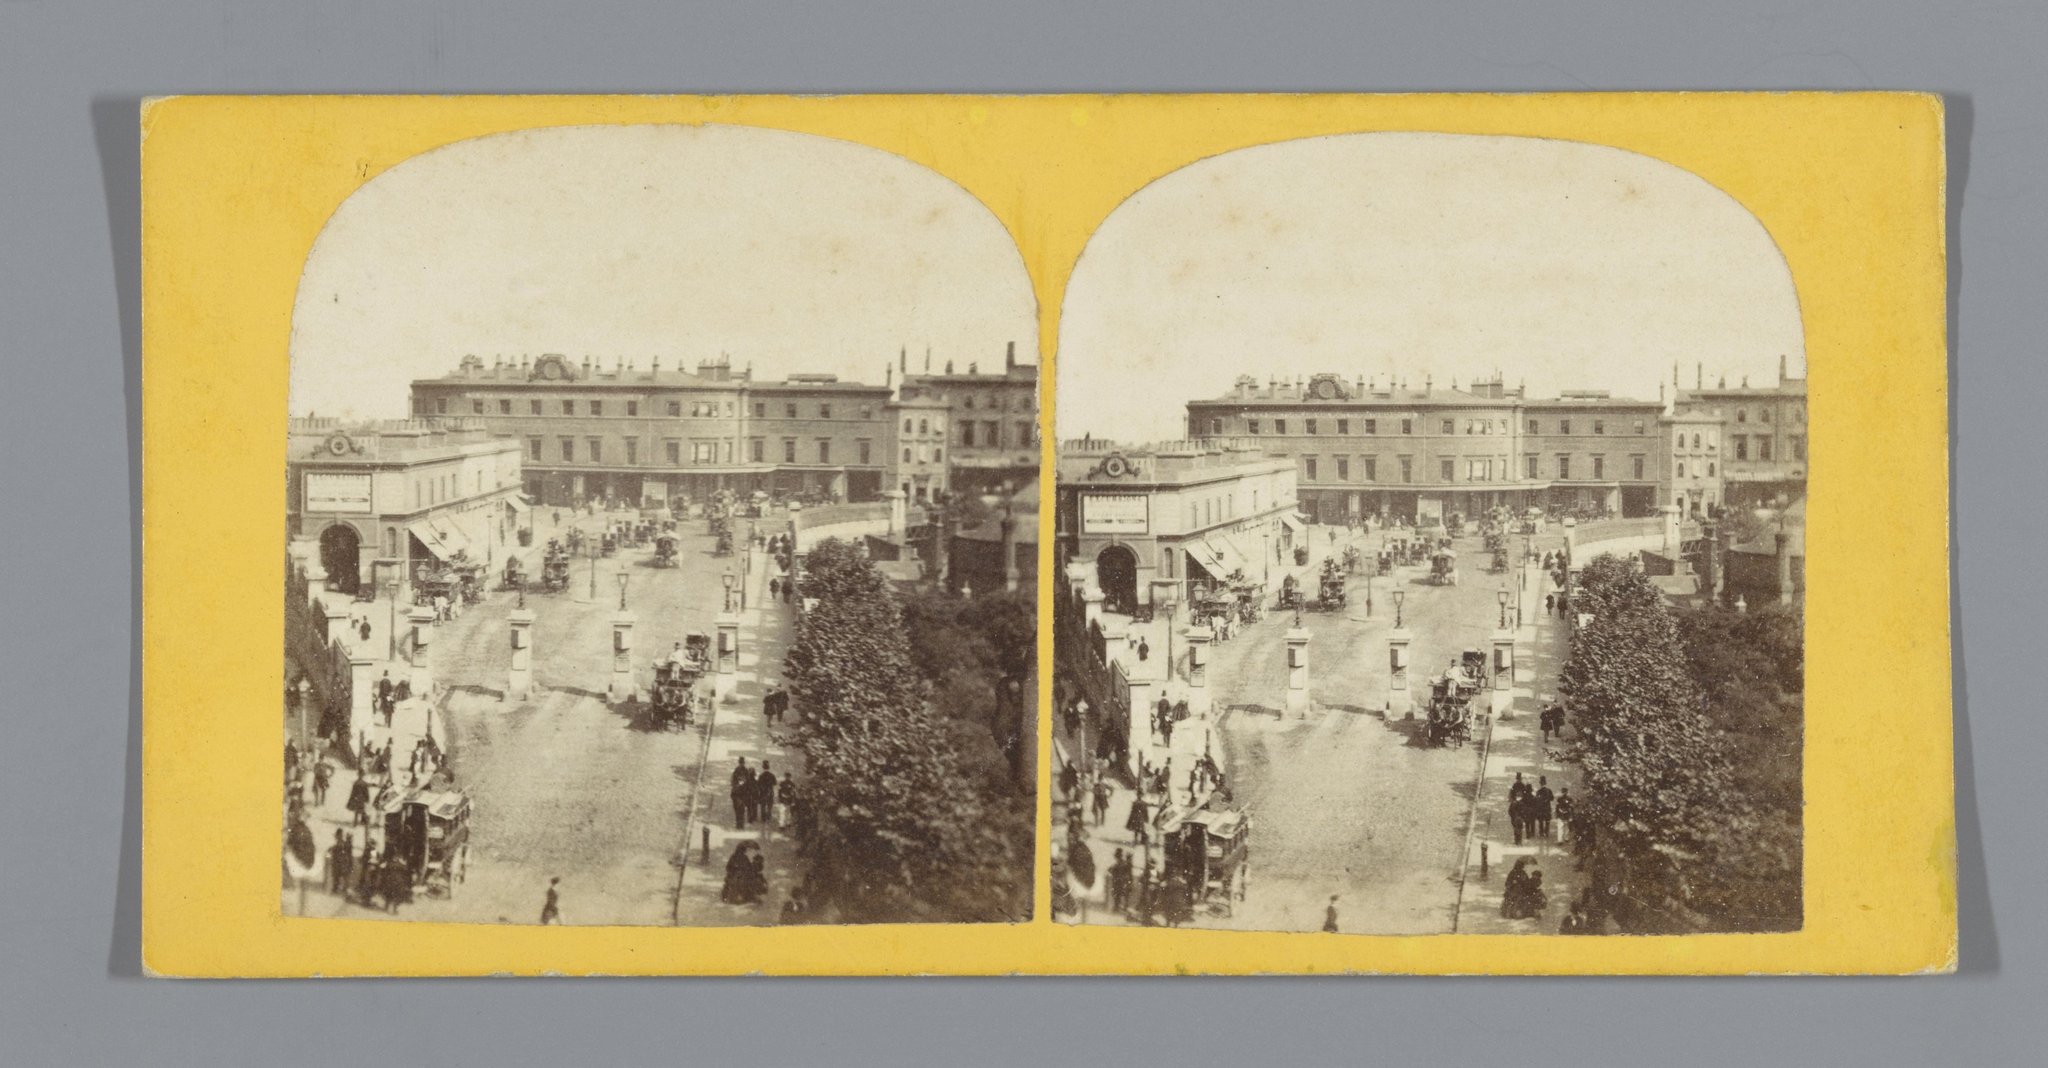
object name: stereograph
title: London Bridge Railway Terminus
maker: Anonymous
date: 1850-1880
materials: cardboard, photographic support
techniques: albumen print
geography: london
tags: four-wheeled, animal-drawn vehicle, e.g.: cab, carriage, coach, railway, train, street, london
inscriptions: inscription: ‘Instantaneous.’, number: ‘103’